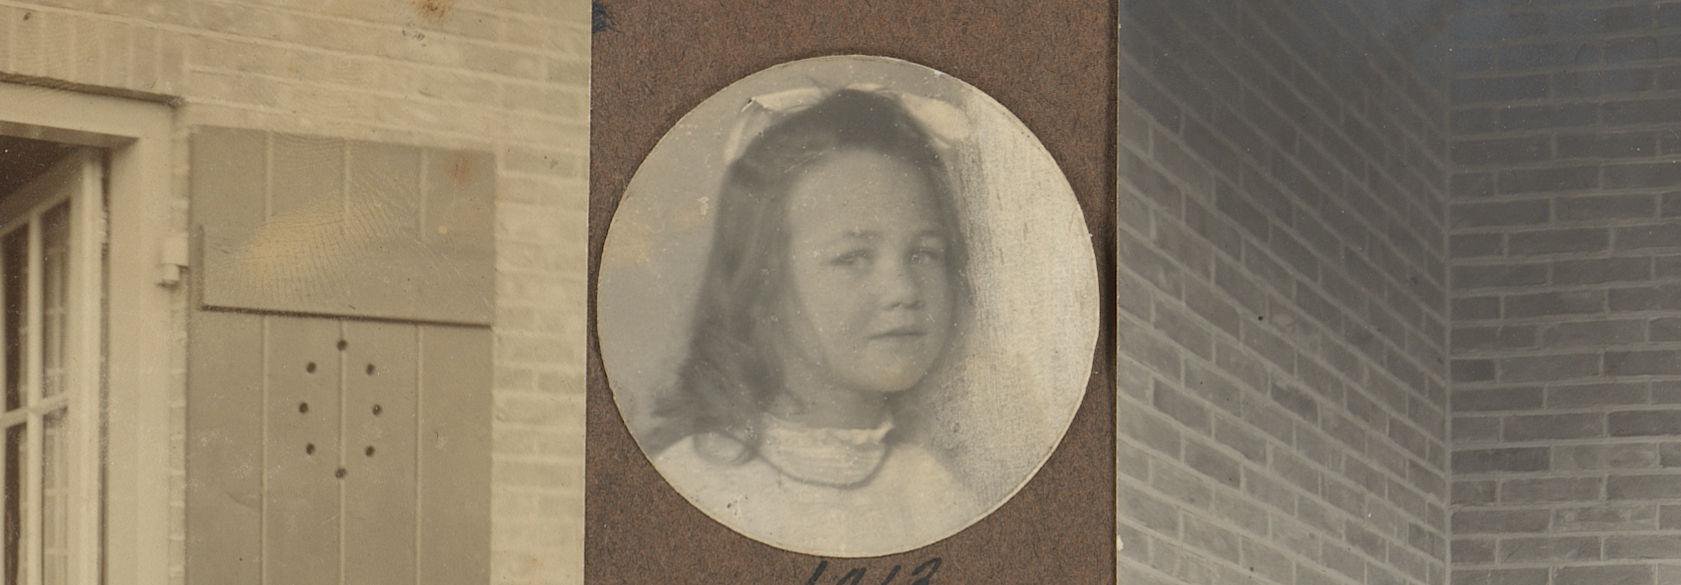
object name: photograph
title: Joanna Diepenbrock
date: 1913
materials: photographic support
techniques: photography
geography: amsterdam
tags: laren, zanger, joanna diepenbrock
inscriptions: date: ‘1913.’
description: Foto op bruin albumblad 19 van familiealbum van Alphons Diepenbrock.